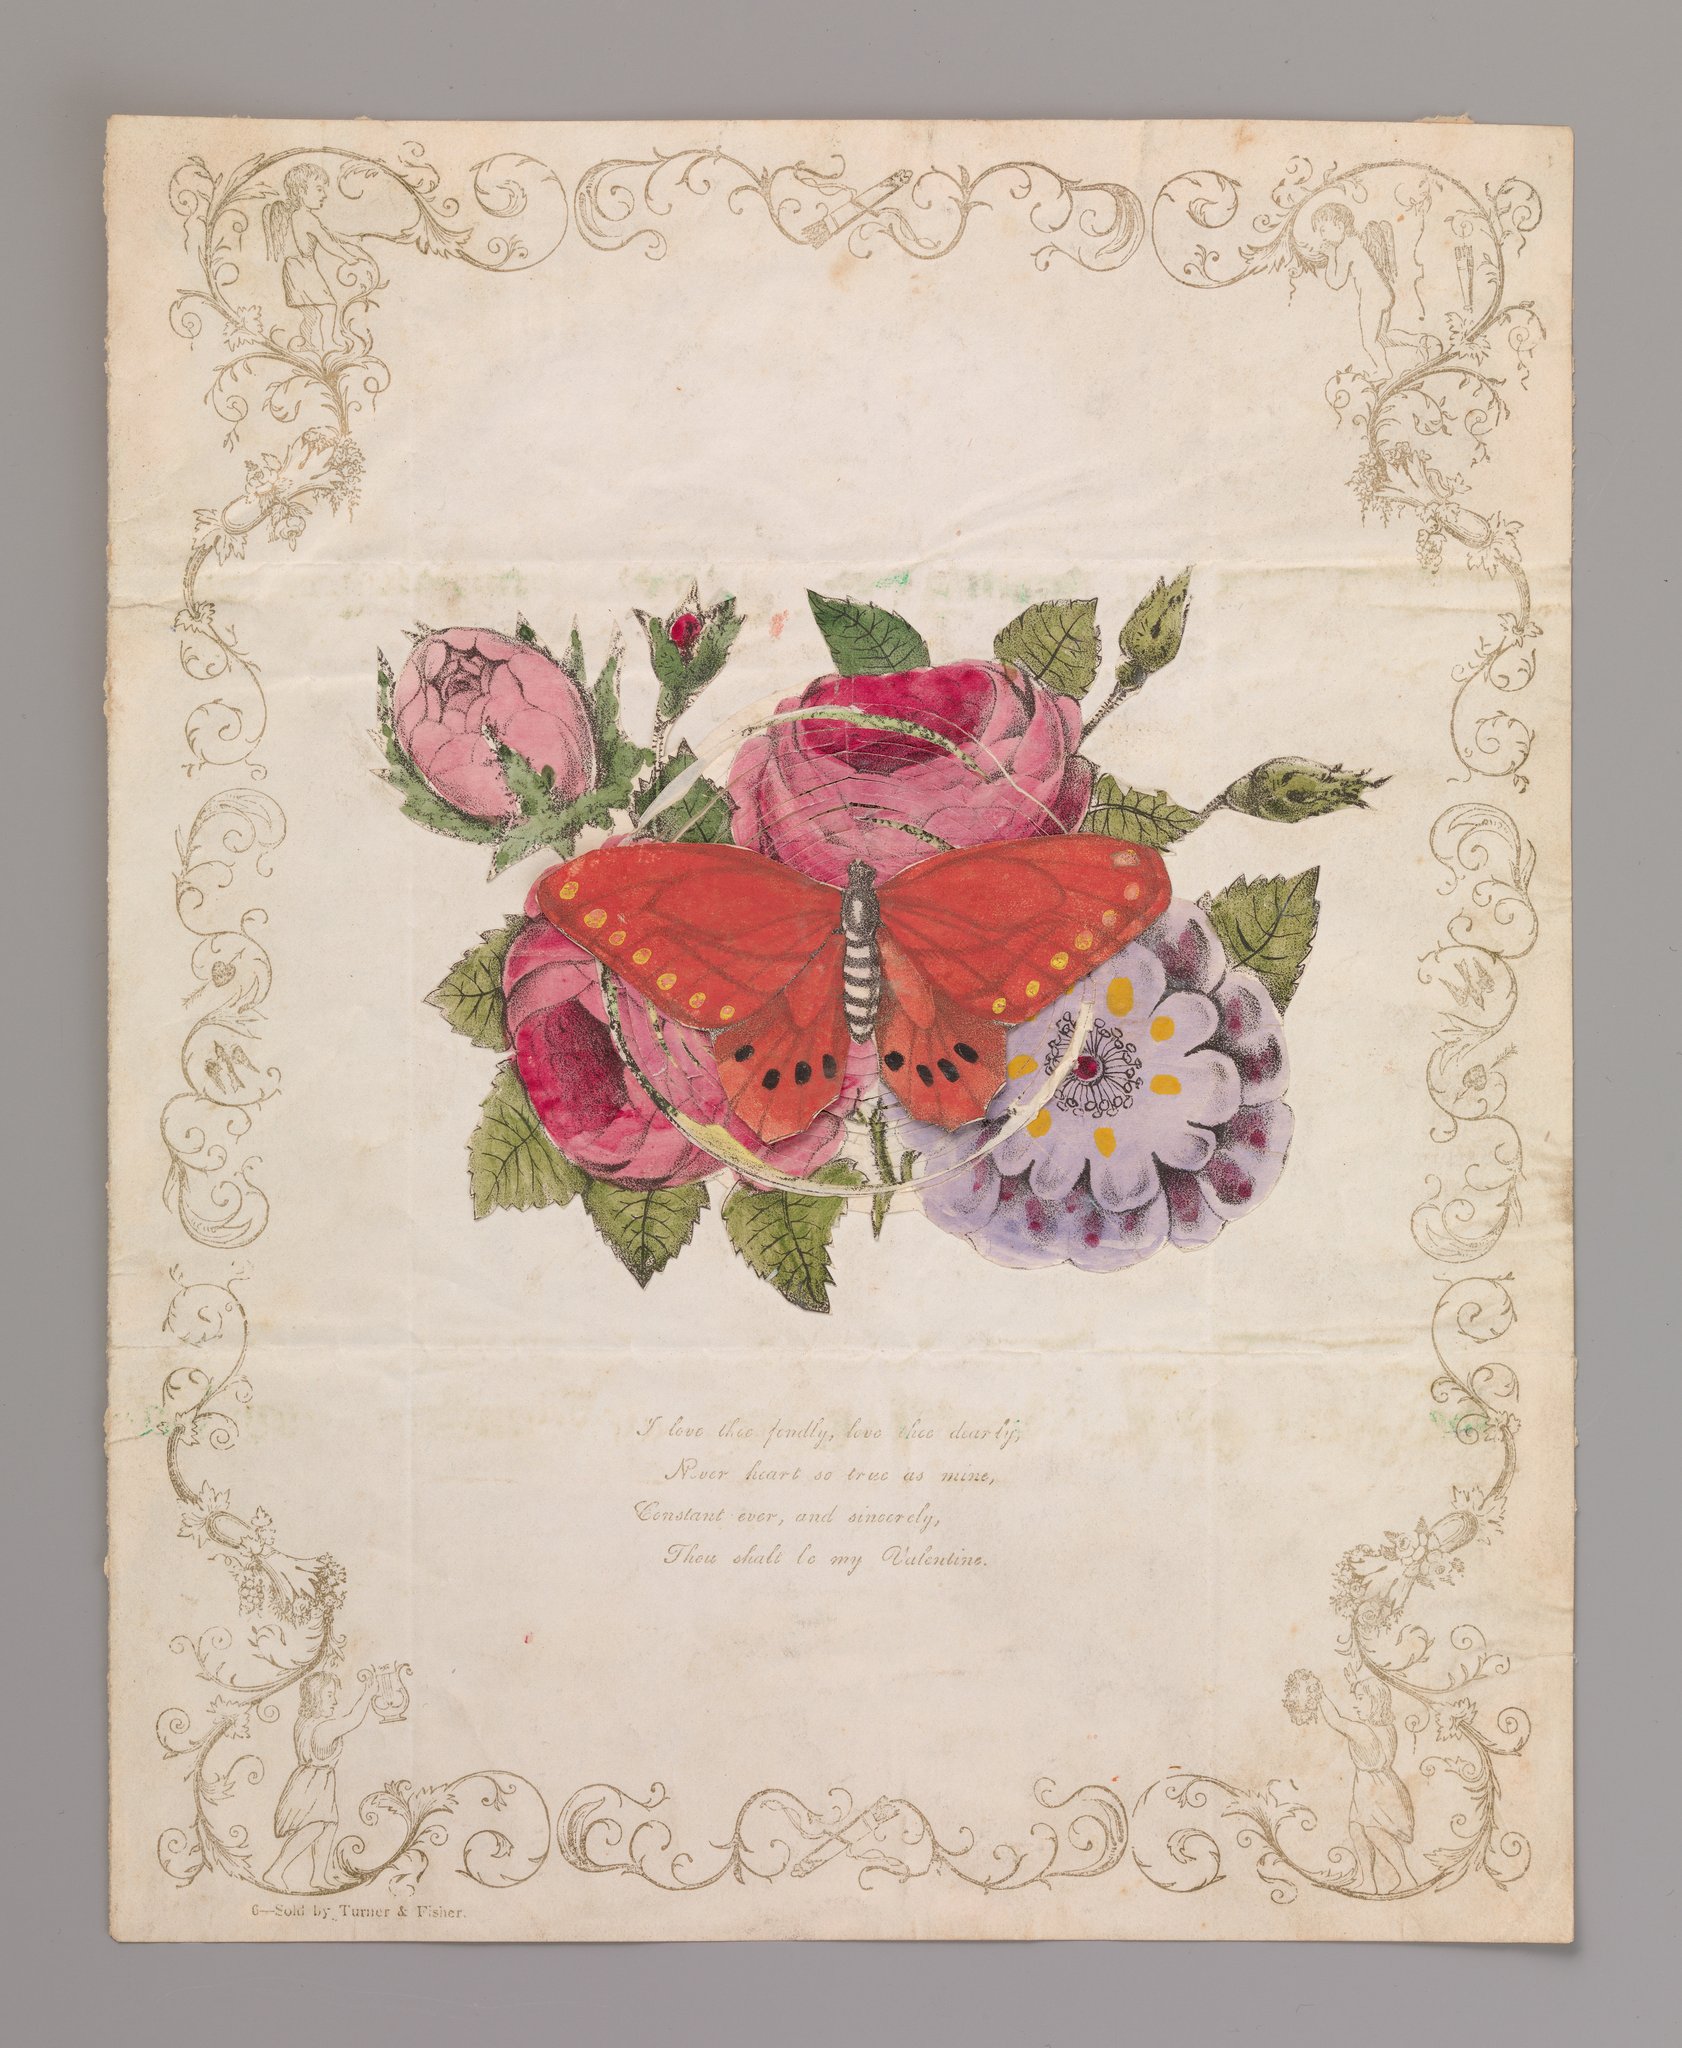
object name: valentine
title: Valentine with Cobweb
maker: Anonymous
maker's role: artist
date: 1841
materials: watercolor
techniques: lithograph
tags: butterflies,flowers